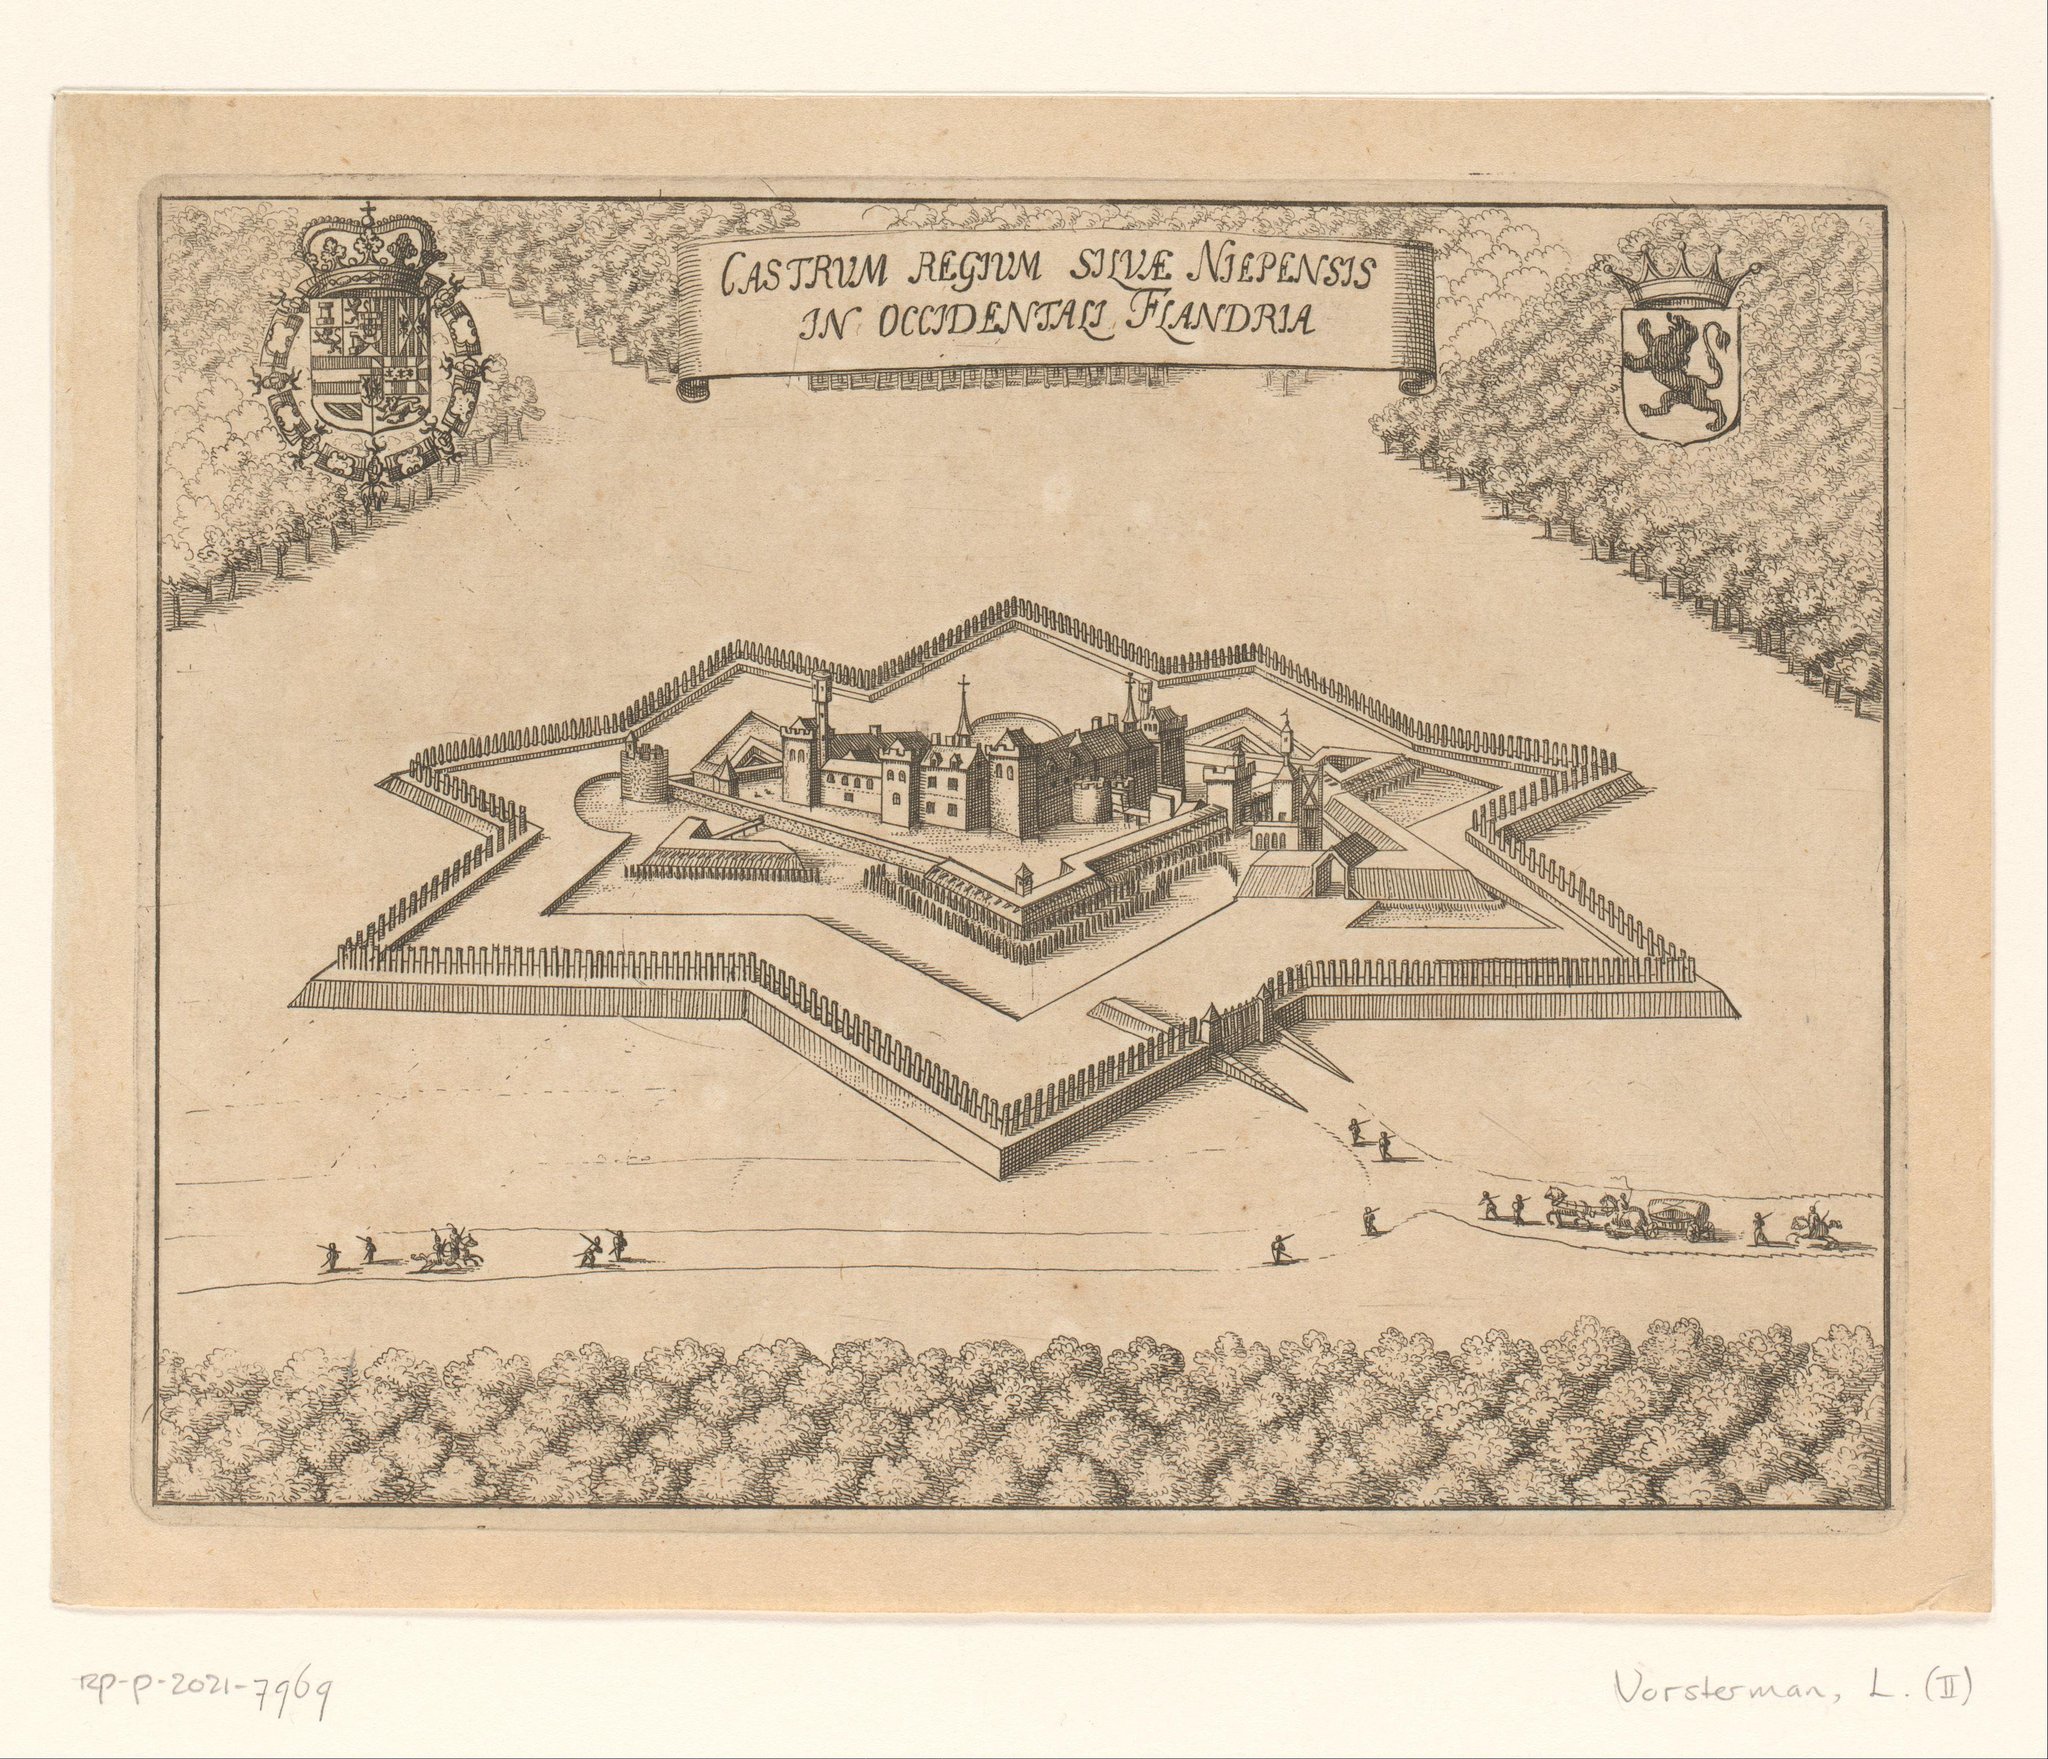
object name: print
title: Castrum Regium Silvae Niepensis in Occidentali Flandria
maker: lucas vorsterman (ii)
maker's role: print maker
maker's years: 1624-1667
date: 1659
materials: paper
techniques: etching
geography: antwerp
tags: fortress, castle, armorial bearing, heraldry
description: Prent waarschijnlijk uit: Sanderus, Antonius. Chorographia sacra Brabantiae. Brussel: Philips Vleugaert, 1659.